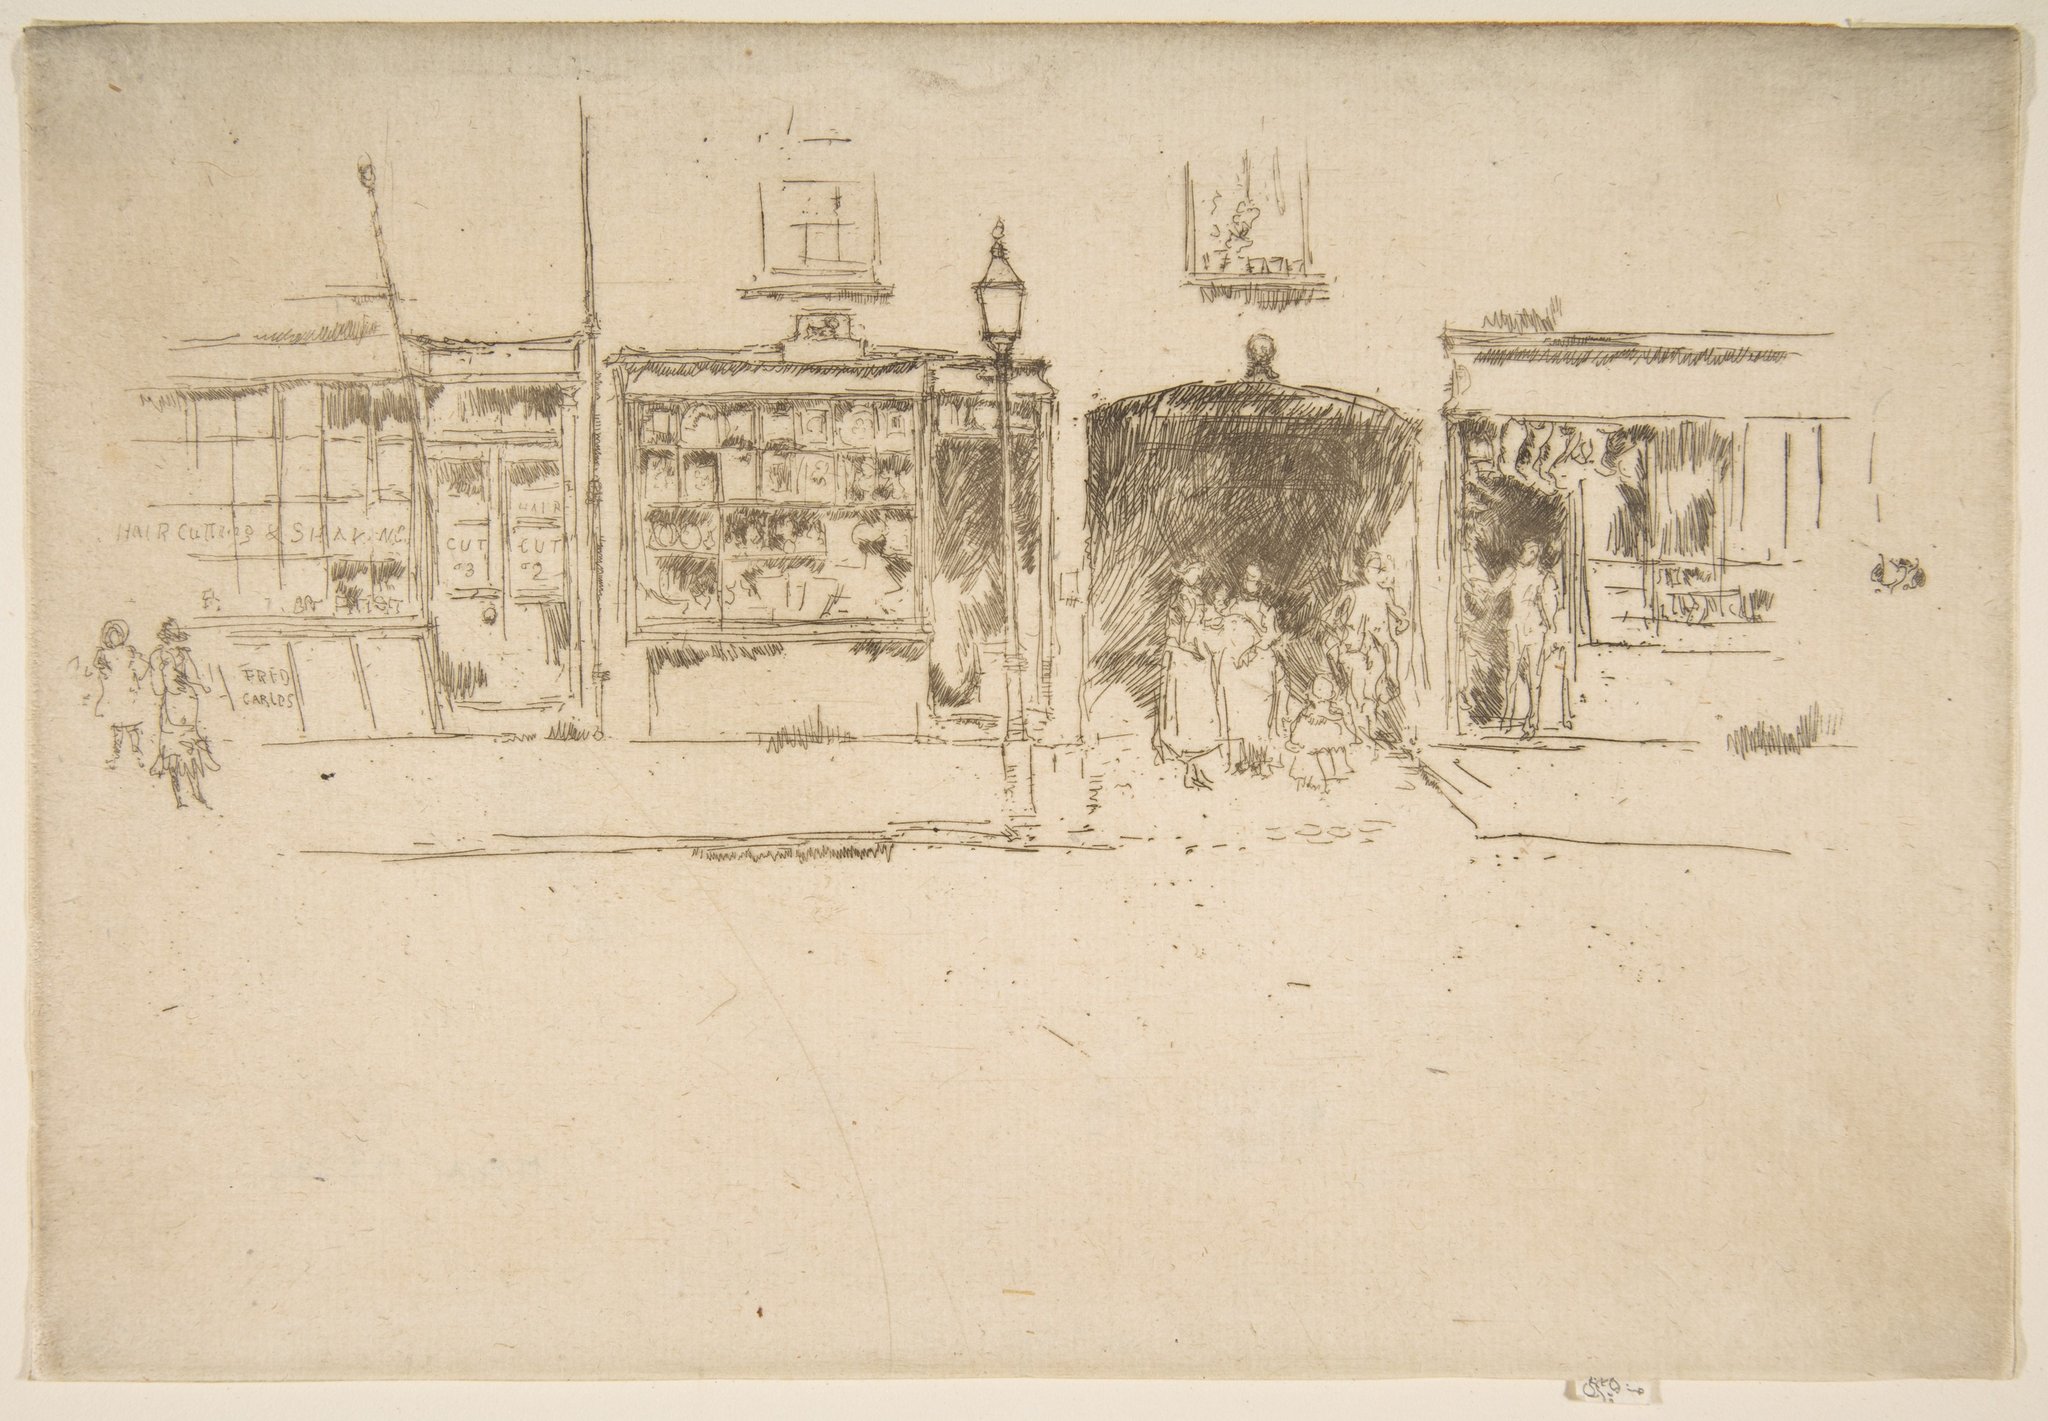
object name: print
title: The Barber's (The Barber's Shop, Chelsea)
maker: james mcneill whistler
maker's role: artist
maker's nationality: american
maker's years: 1834-1903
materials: ink, paper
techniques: drypoint, etching, printing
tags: shops,london